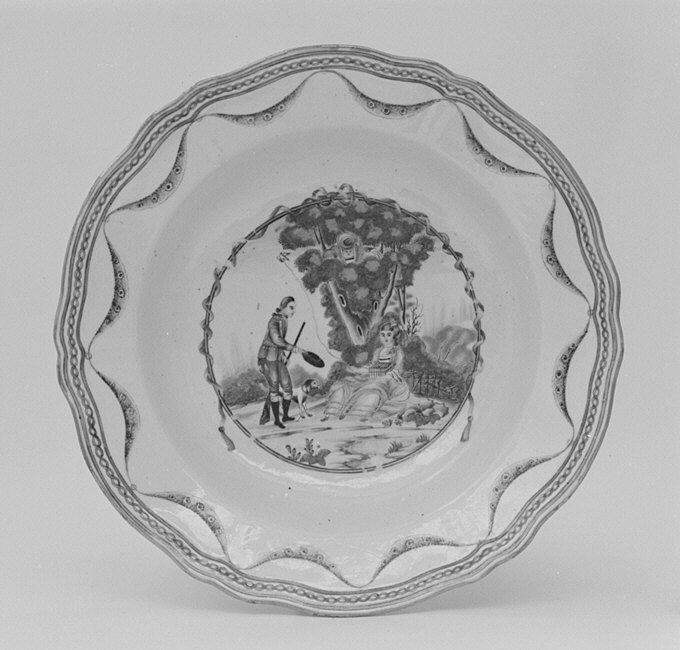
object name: soup plate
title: Soup plate (part of a service)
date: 1750-1770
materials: hard paste porcelain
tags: men,women